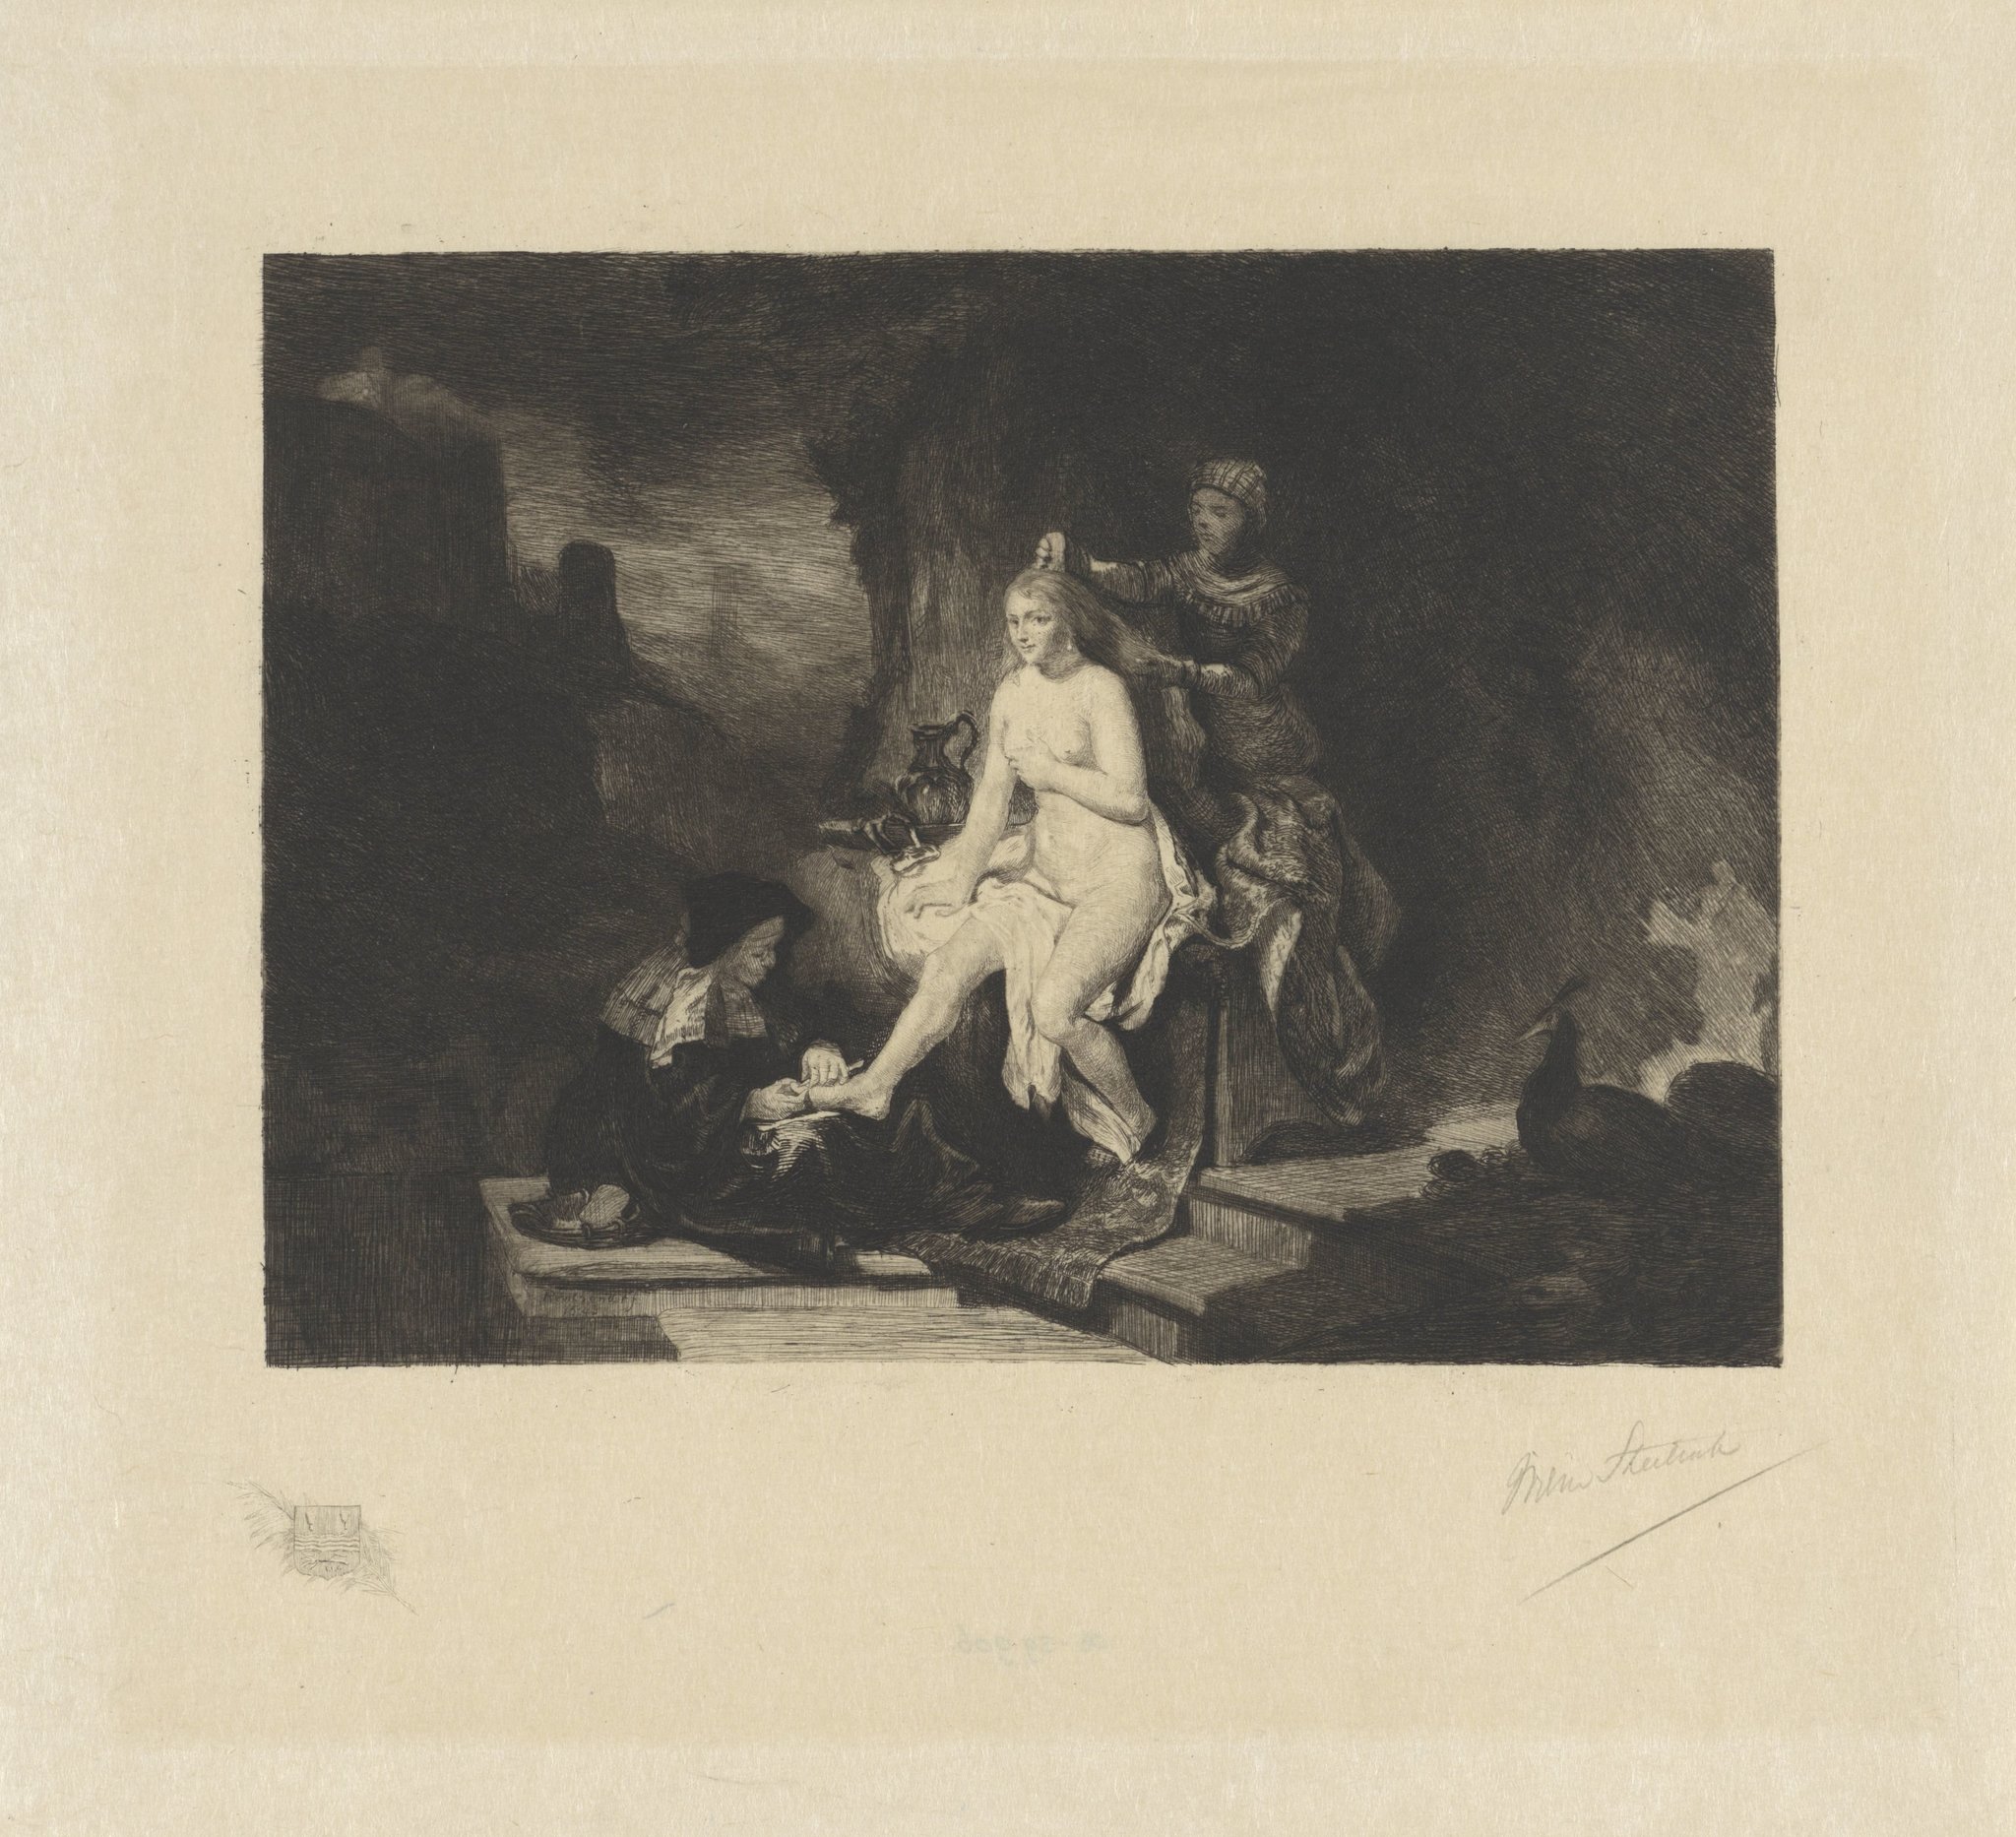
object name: print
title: Toilet van Batseba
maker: willem steelink (ii)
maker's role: draughtsman, print maker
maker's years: 1856-1928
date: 1888-1891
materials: paper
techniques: etching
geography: netherlands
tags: bathsheba attended by servant(s)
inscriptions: collector's mark: Lugt 2228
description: Een dienares kamt de haren van Batseba. Een oude vrouw knipt of veilt haar teennagels. Linksonder in de marge een wapenschild op een takje met bladeren.